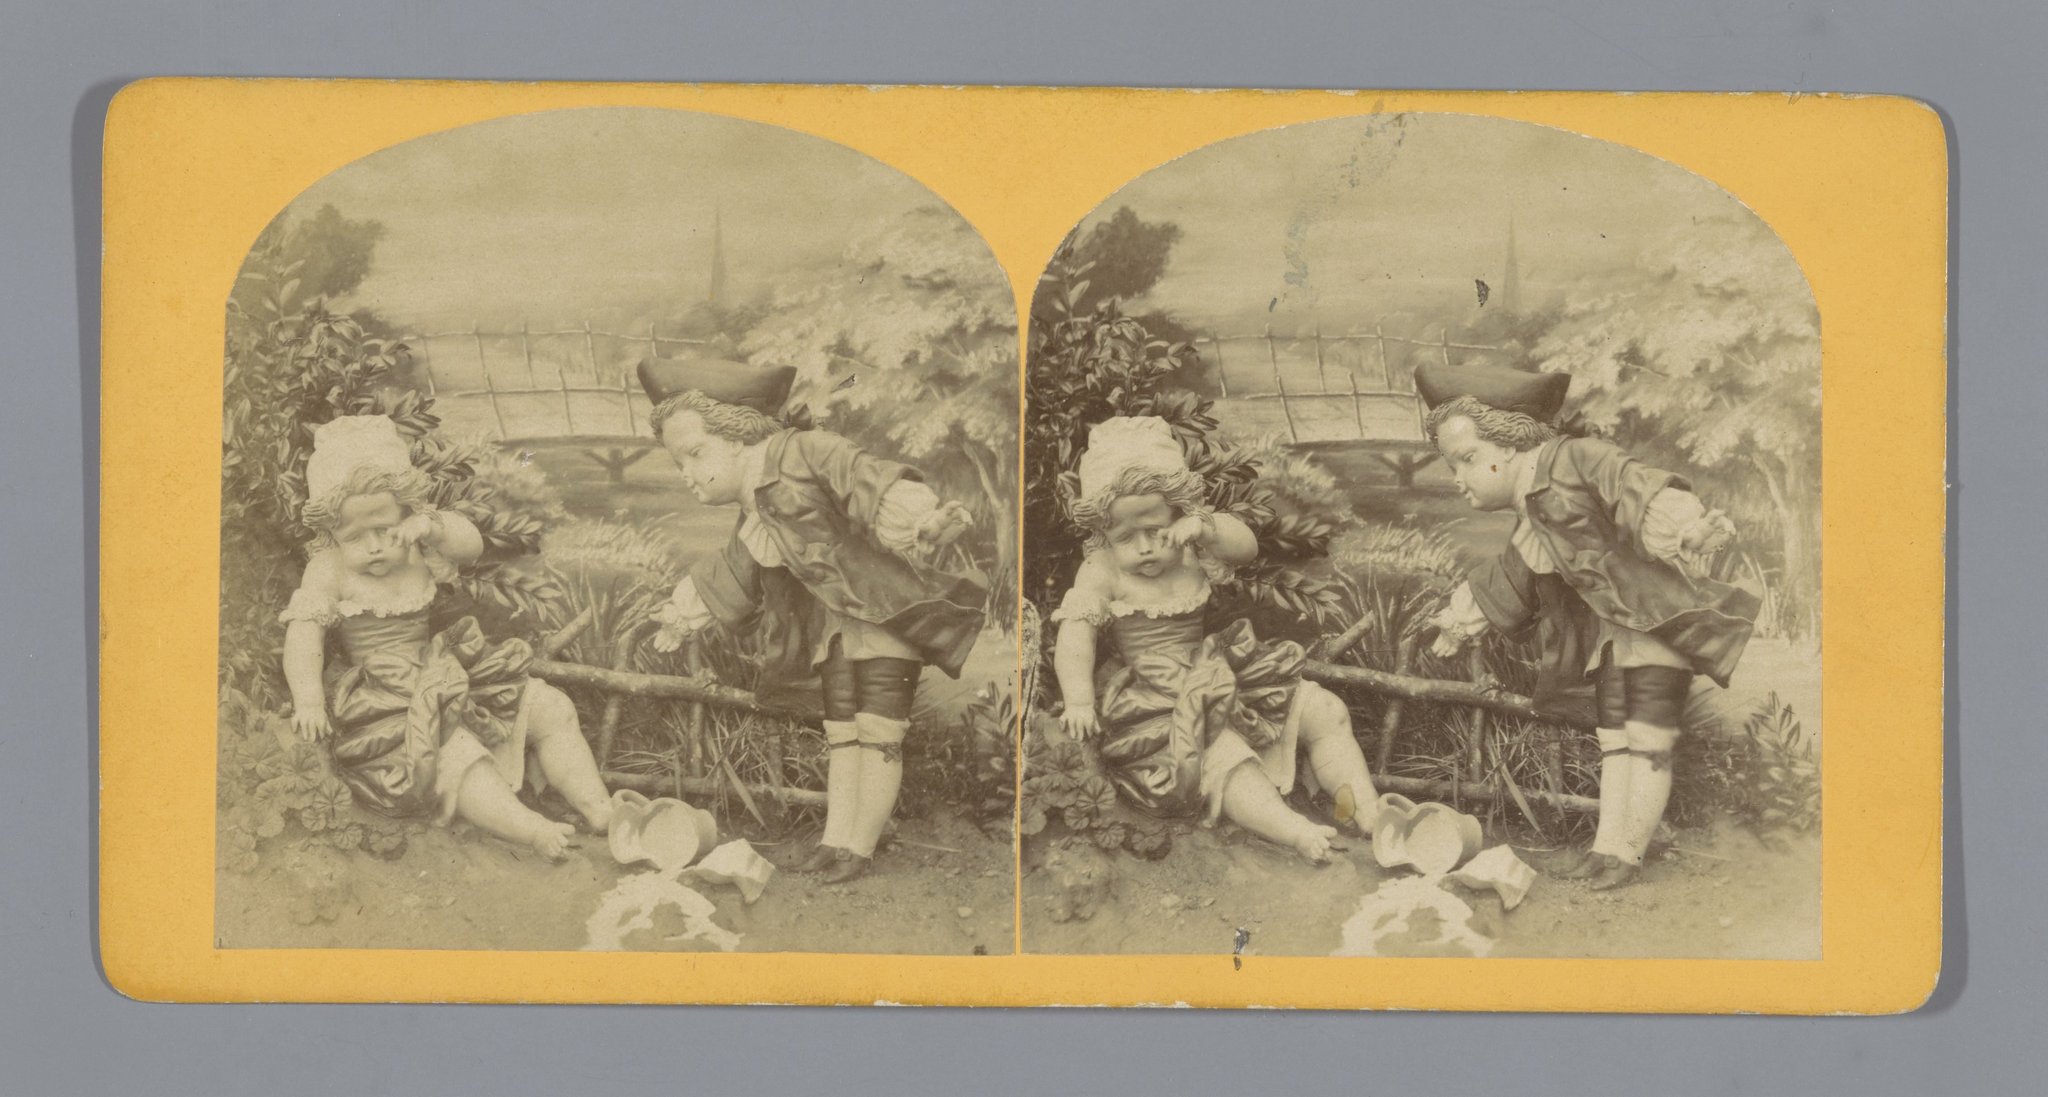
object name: stereograph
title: Enscenering met twee poppen, voorstellend een huilend meisje met een gebroken kan en een jongen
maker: Anonymous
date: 1850-1880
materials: cardboard, photographic support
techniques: albumen print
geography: europe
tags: set, scenery ~ stage, (playing with) dolls, europe